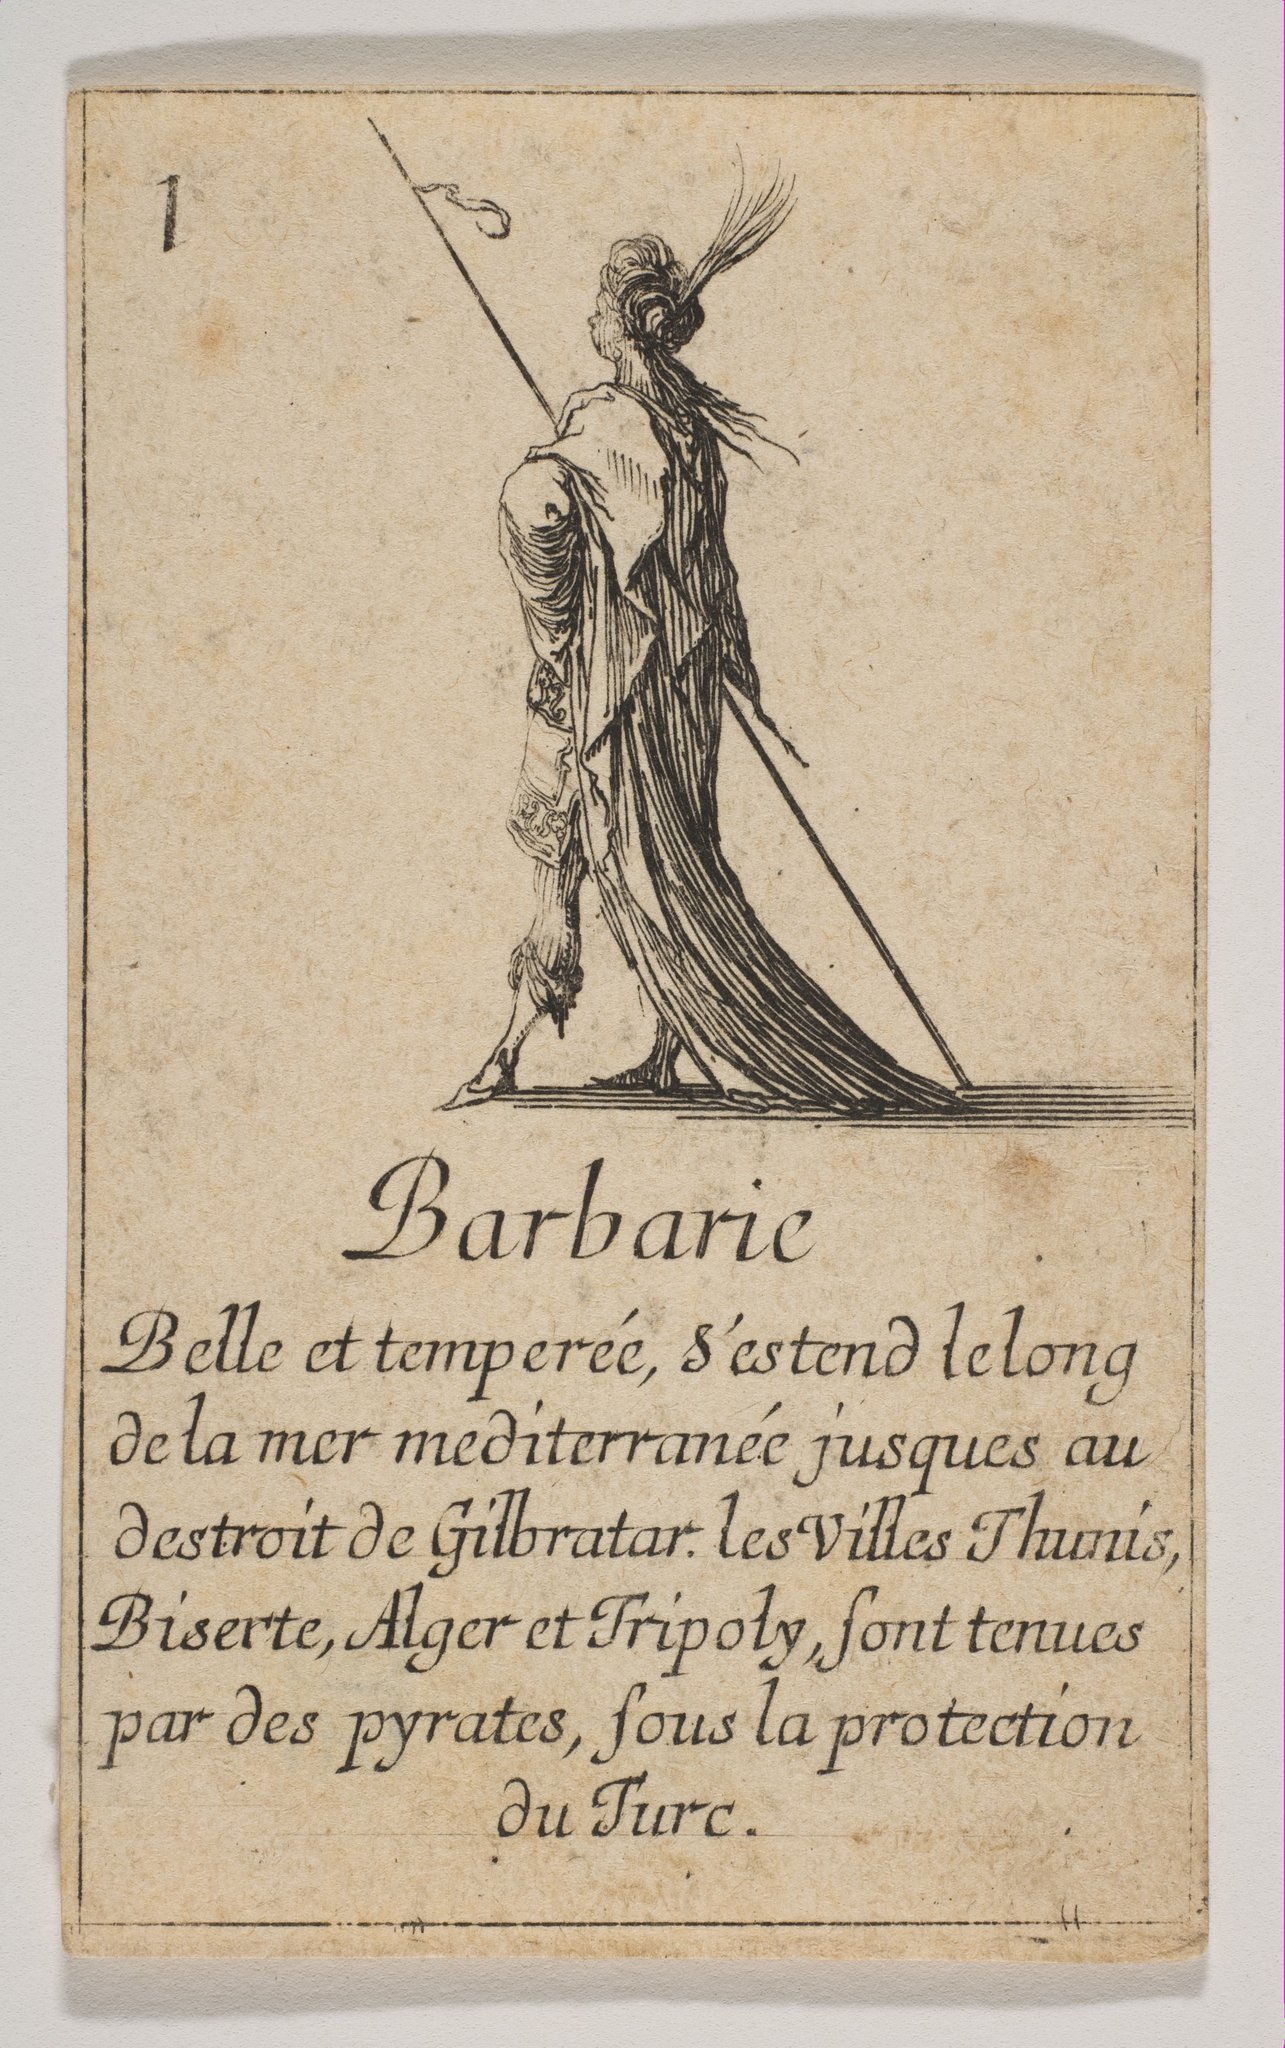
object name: print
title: Barbarie, from "Jeu de la Géographie"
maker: stefano della bella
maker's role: artist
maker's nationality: italian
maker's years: 1610-1664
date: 1644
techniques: etching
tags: spears,women